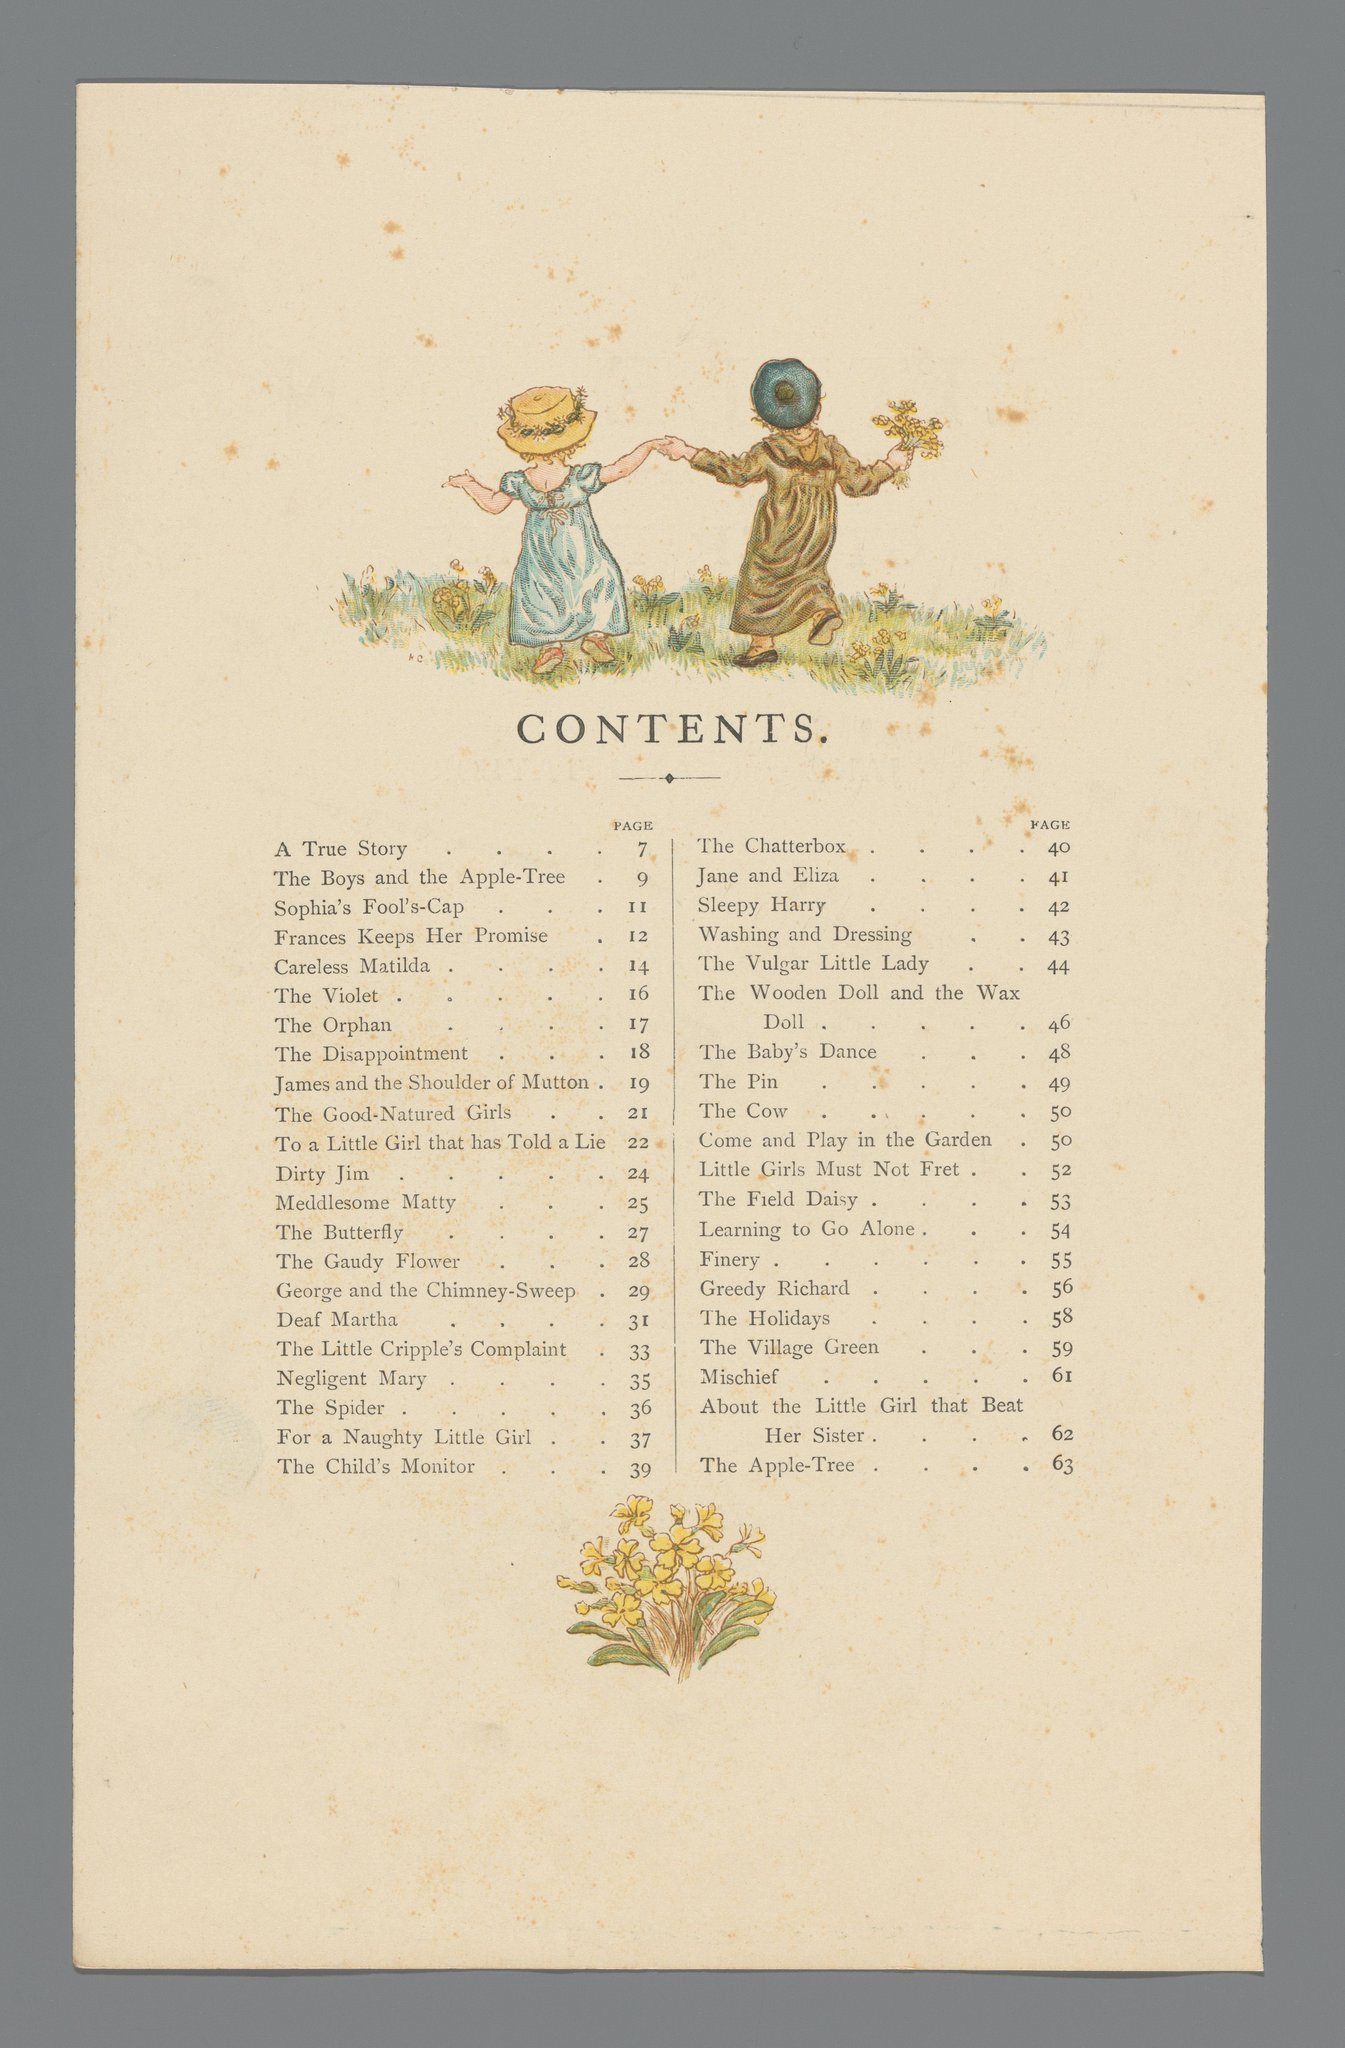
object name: book illustration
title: Twee kinderen hand in hand in een bloemenveld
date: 1883-1927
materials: paper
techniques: wood engraving, letterpress printing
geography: london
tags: picking flowers, arm in arm (friends), child (+ two persons)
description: Prent uit: Jane en Ann Taylor. Little Ann and other poems. Londen: George Routledge & Sons, [1883].